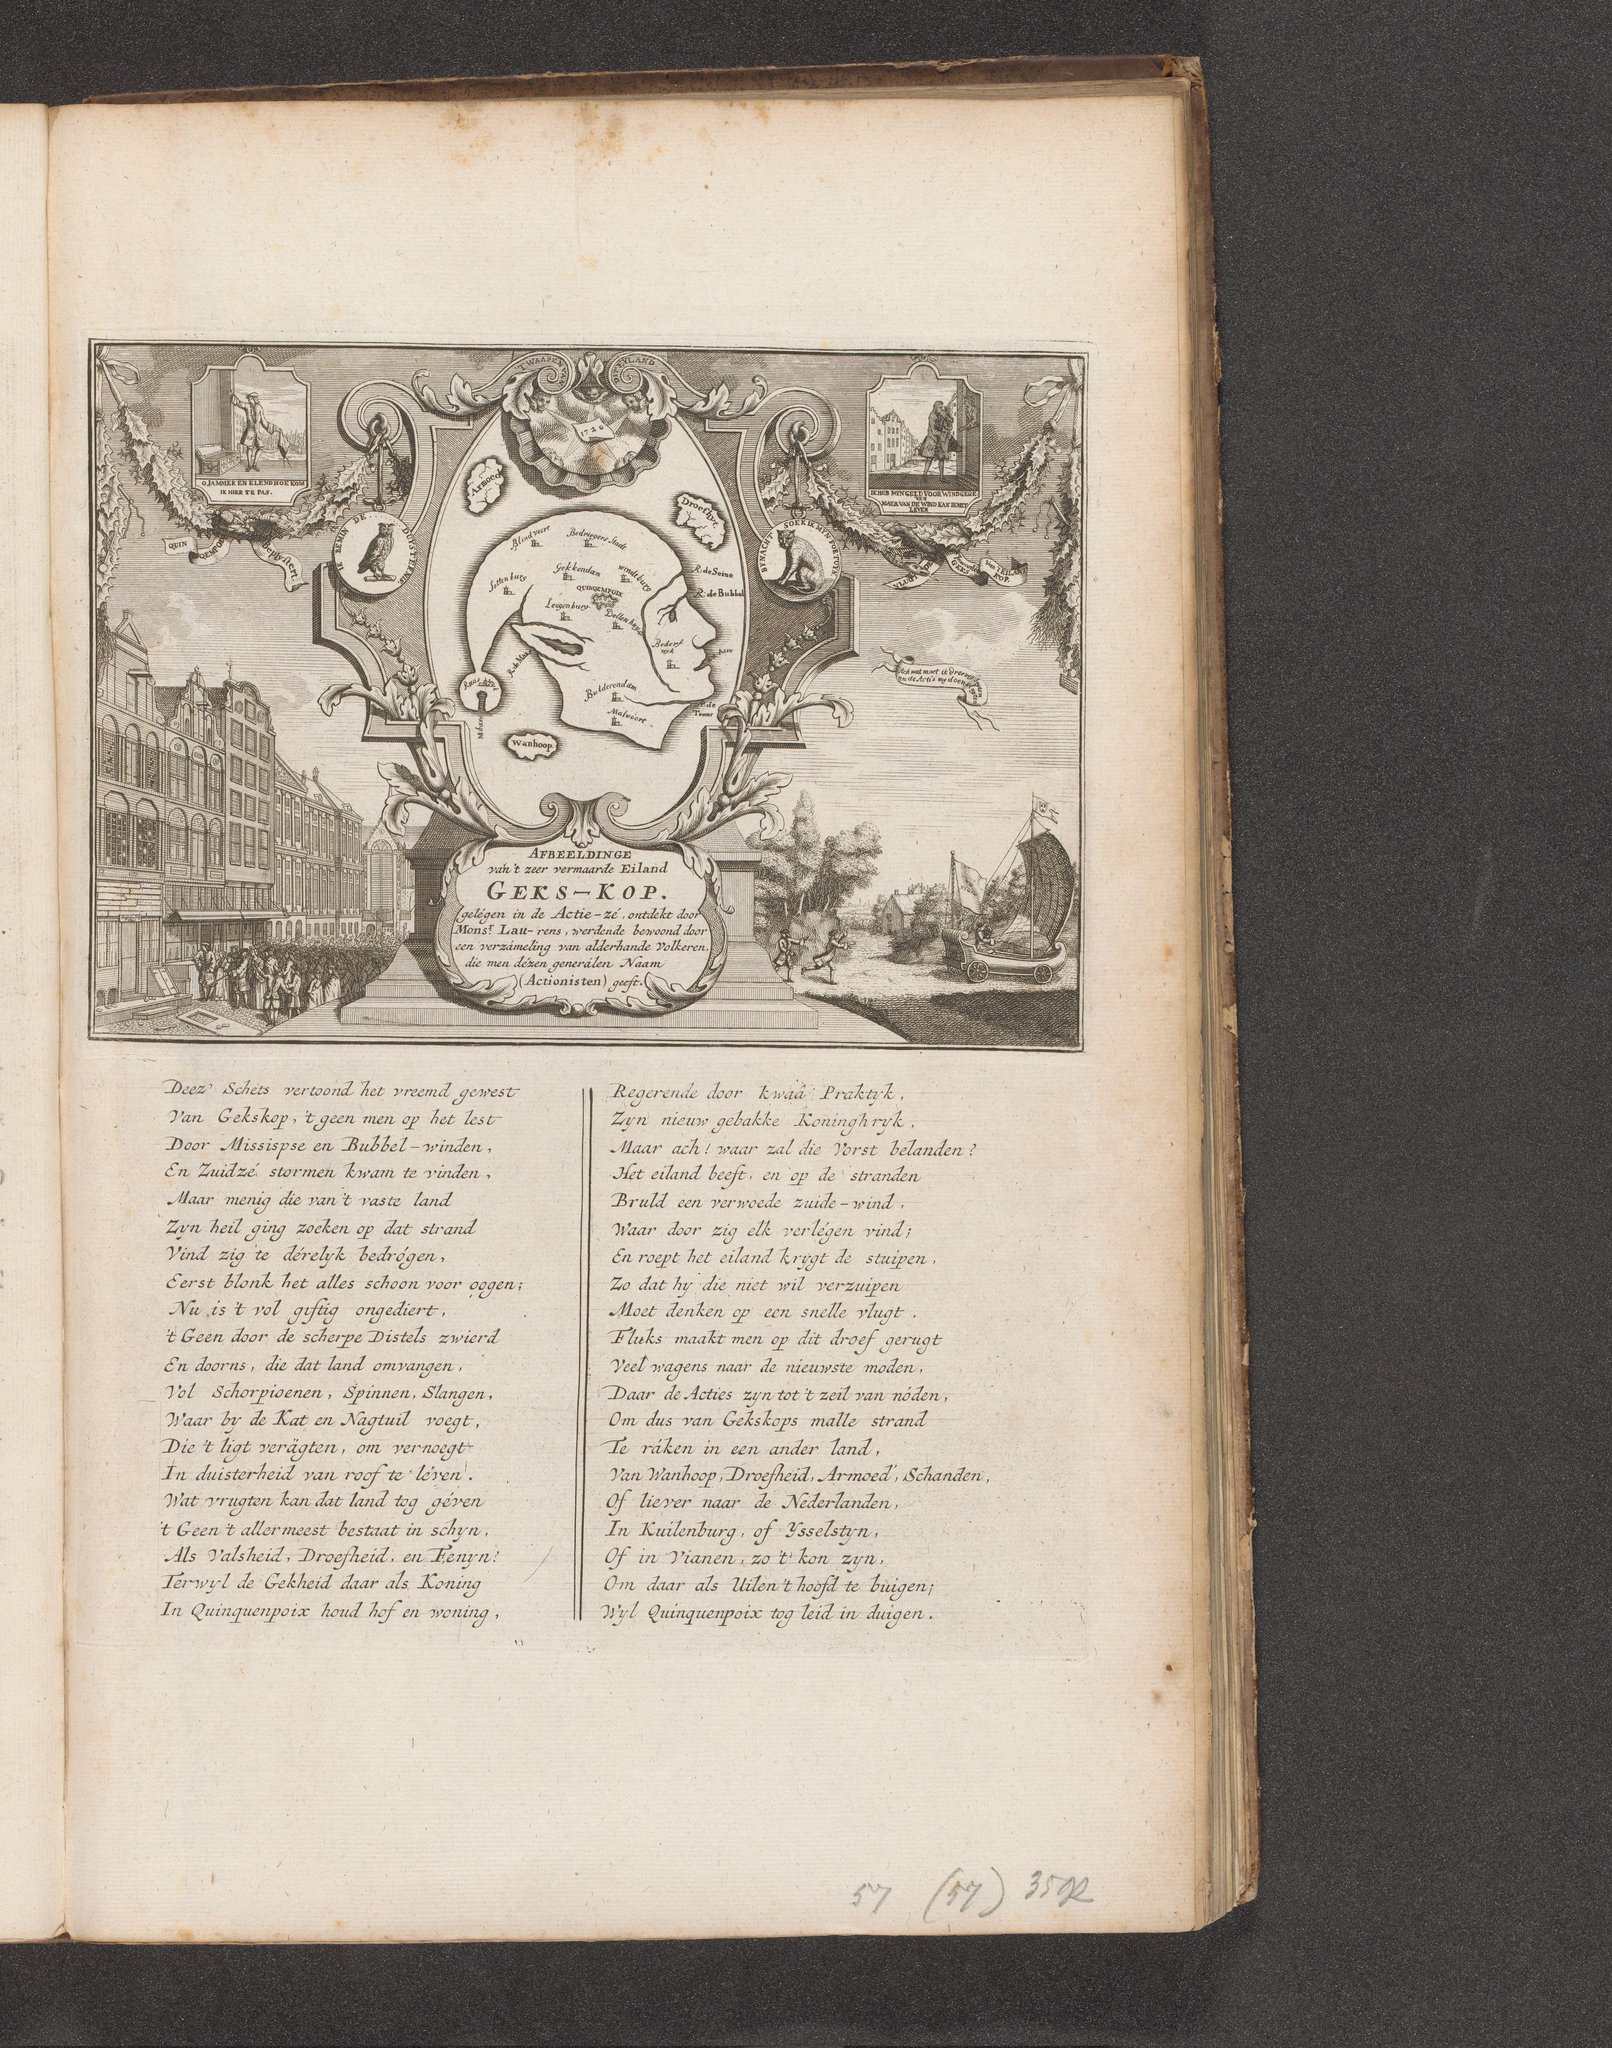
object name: cartoon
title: Afbeeldinge van 't zeer vermaarde eiland Geks-Kop (…)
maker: Anonymous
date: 1720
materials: paper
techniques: engraving, etching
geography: northern netherlands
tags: court jester, court fool, financial panic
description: Kaart van het eiland Gekskop in de vorm van de kop van een nar. Aan de linkerkant een oproerige menigte voor het koffiehuis Quincampoix in Amsterdam, rechts de zeilwagen met vaandel: na Viane. Op het blad onder de plaat het onderschrift in twee kolommen van een aparte plaat gedrukt. Prent in de gebonden vierde uitgave (304 B 12) van Het Groote Tafereel der Dwaasheid met spotprenten op de Windhandel of Actiehandel van 1720.